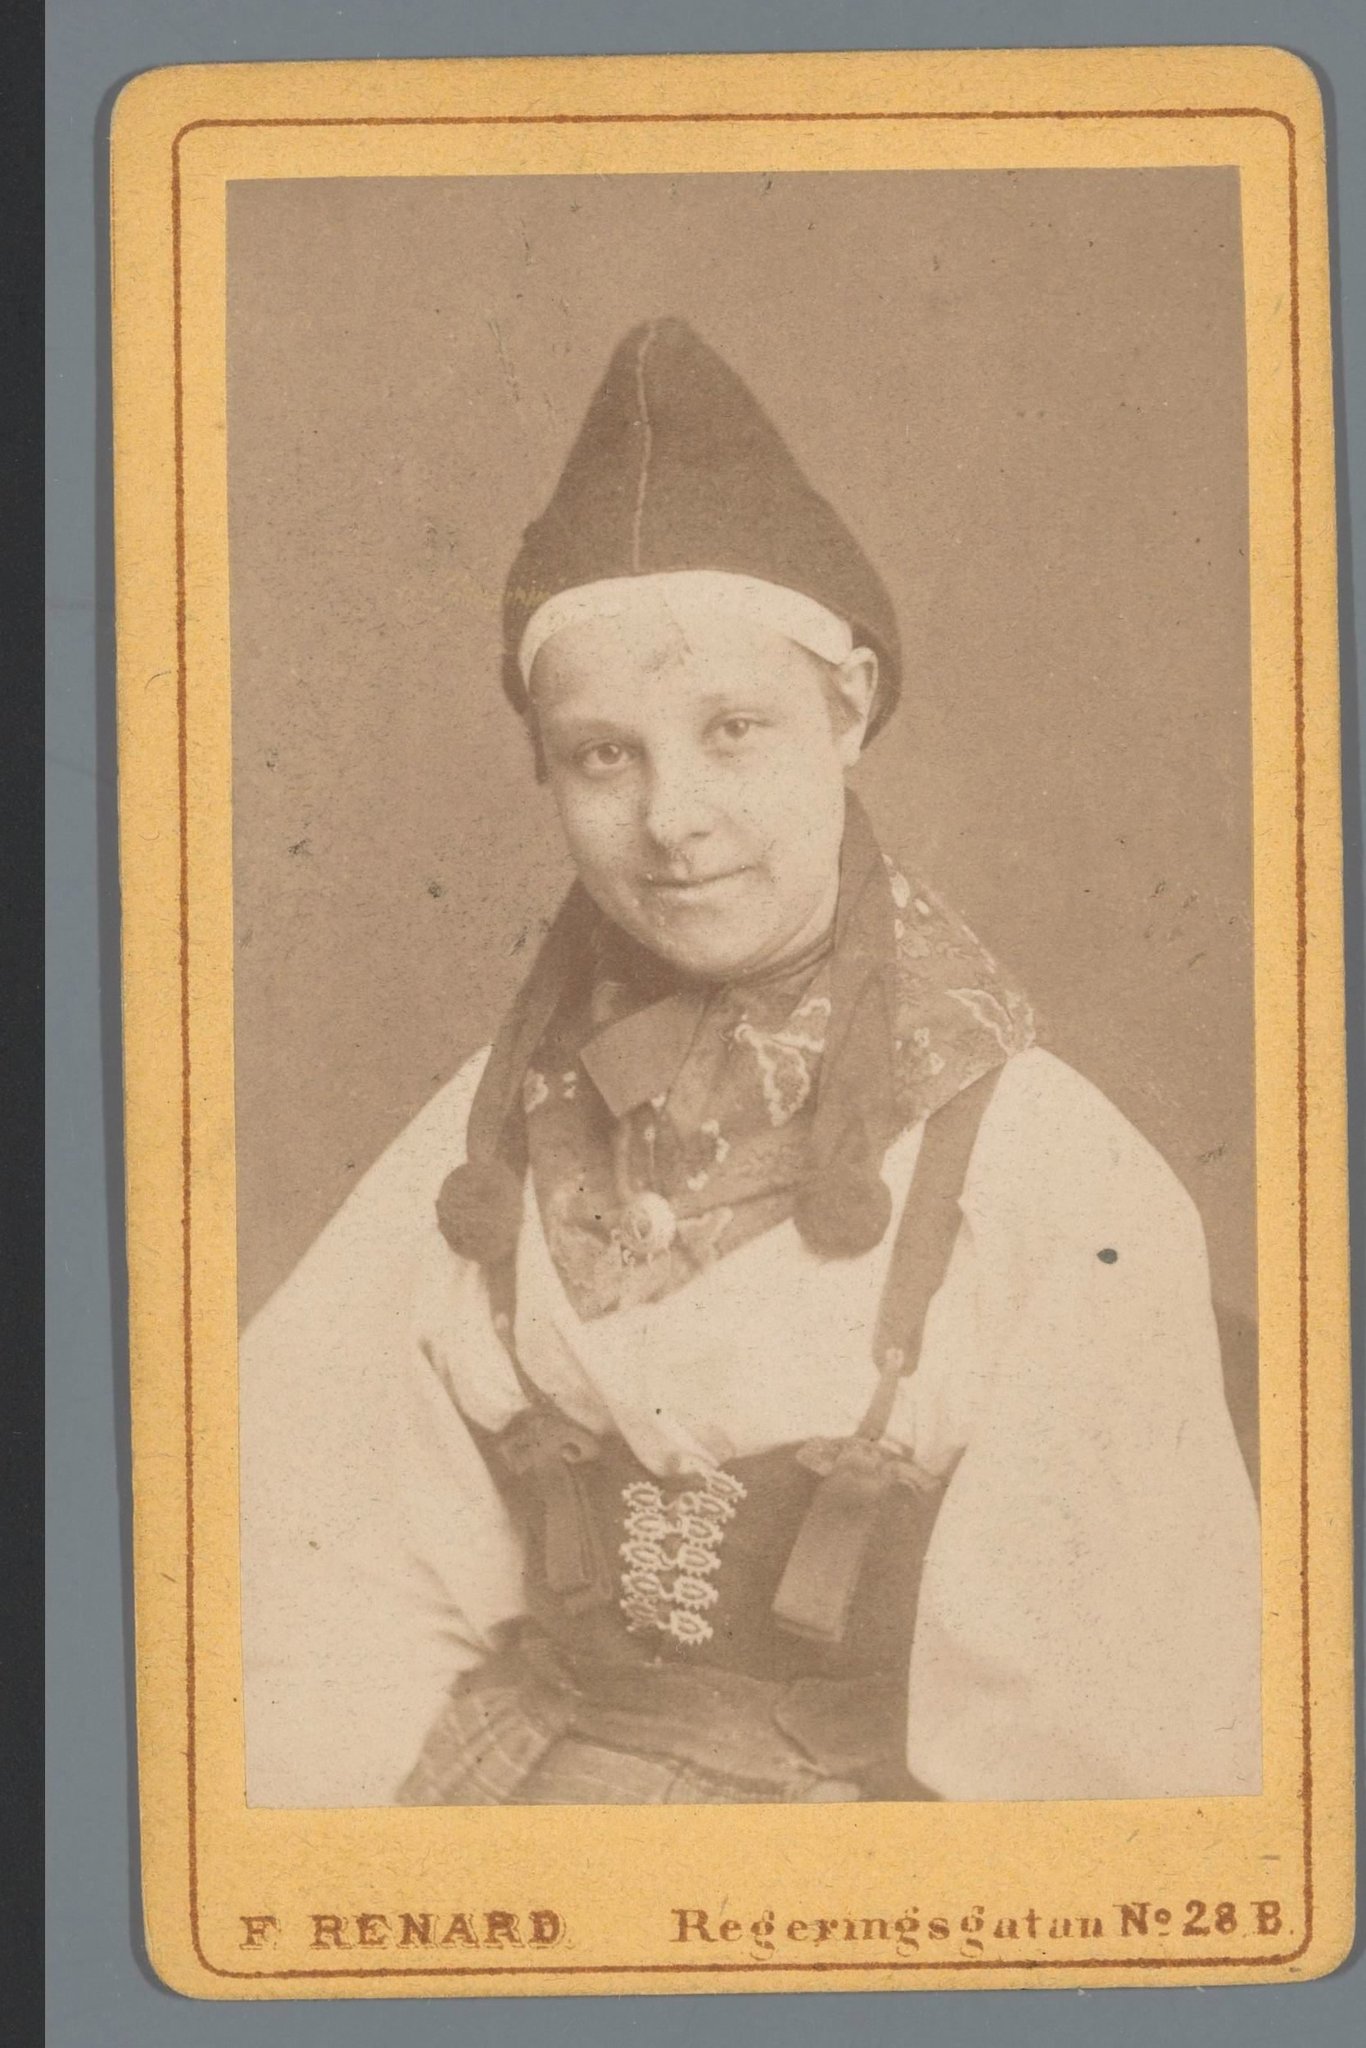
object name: carte de visite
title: Portret van een onbekende jonge vrouw in klederdracht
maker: frederik renard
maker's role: fotograaf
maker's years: 1824-1895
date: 1865-1880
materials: cardboard, paper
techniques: albumen print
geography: stockholm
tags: adult woman, anonymous historical person portrayed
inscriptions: inscription: ‘Plåten förvaras för efterbeställning.’, address: ‘Stockholm/ Regeringsgatan No 28, B.’